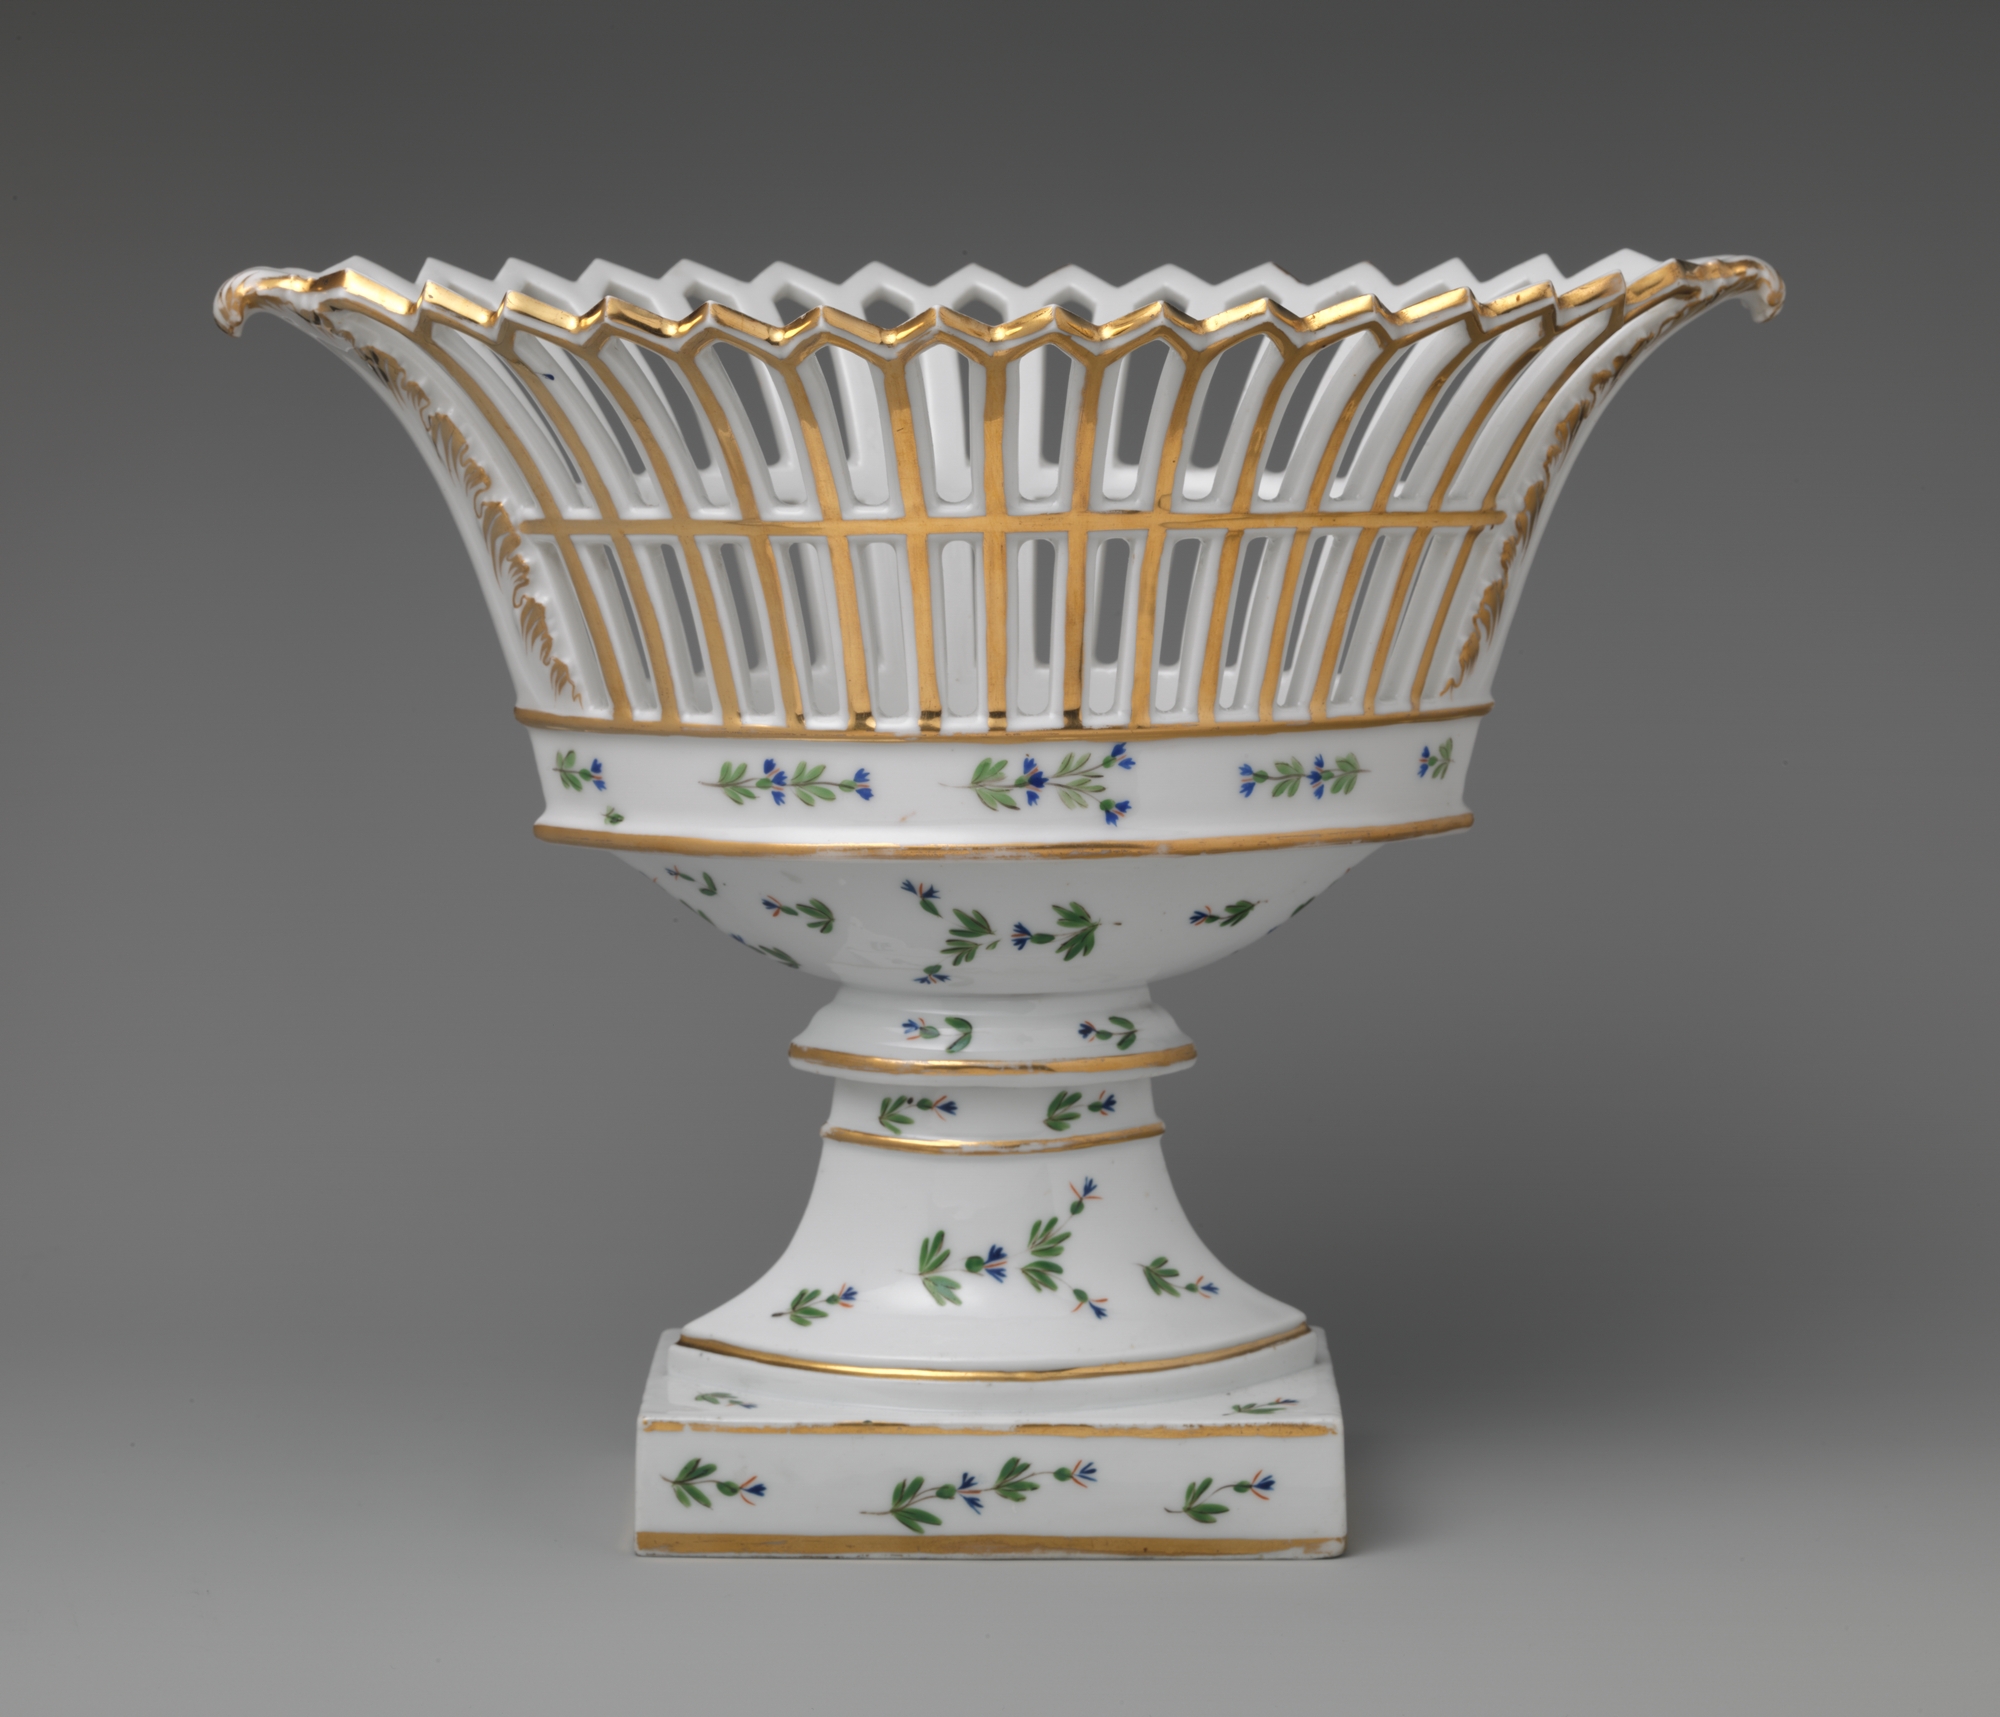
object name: compote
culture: french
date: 1815-1830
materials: porcelain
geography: france